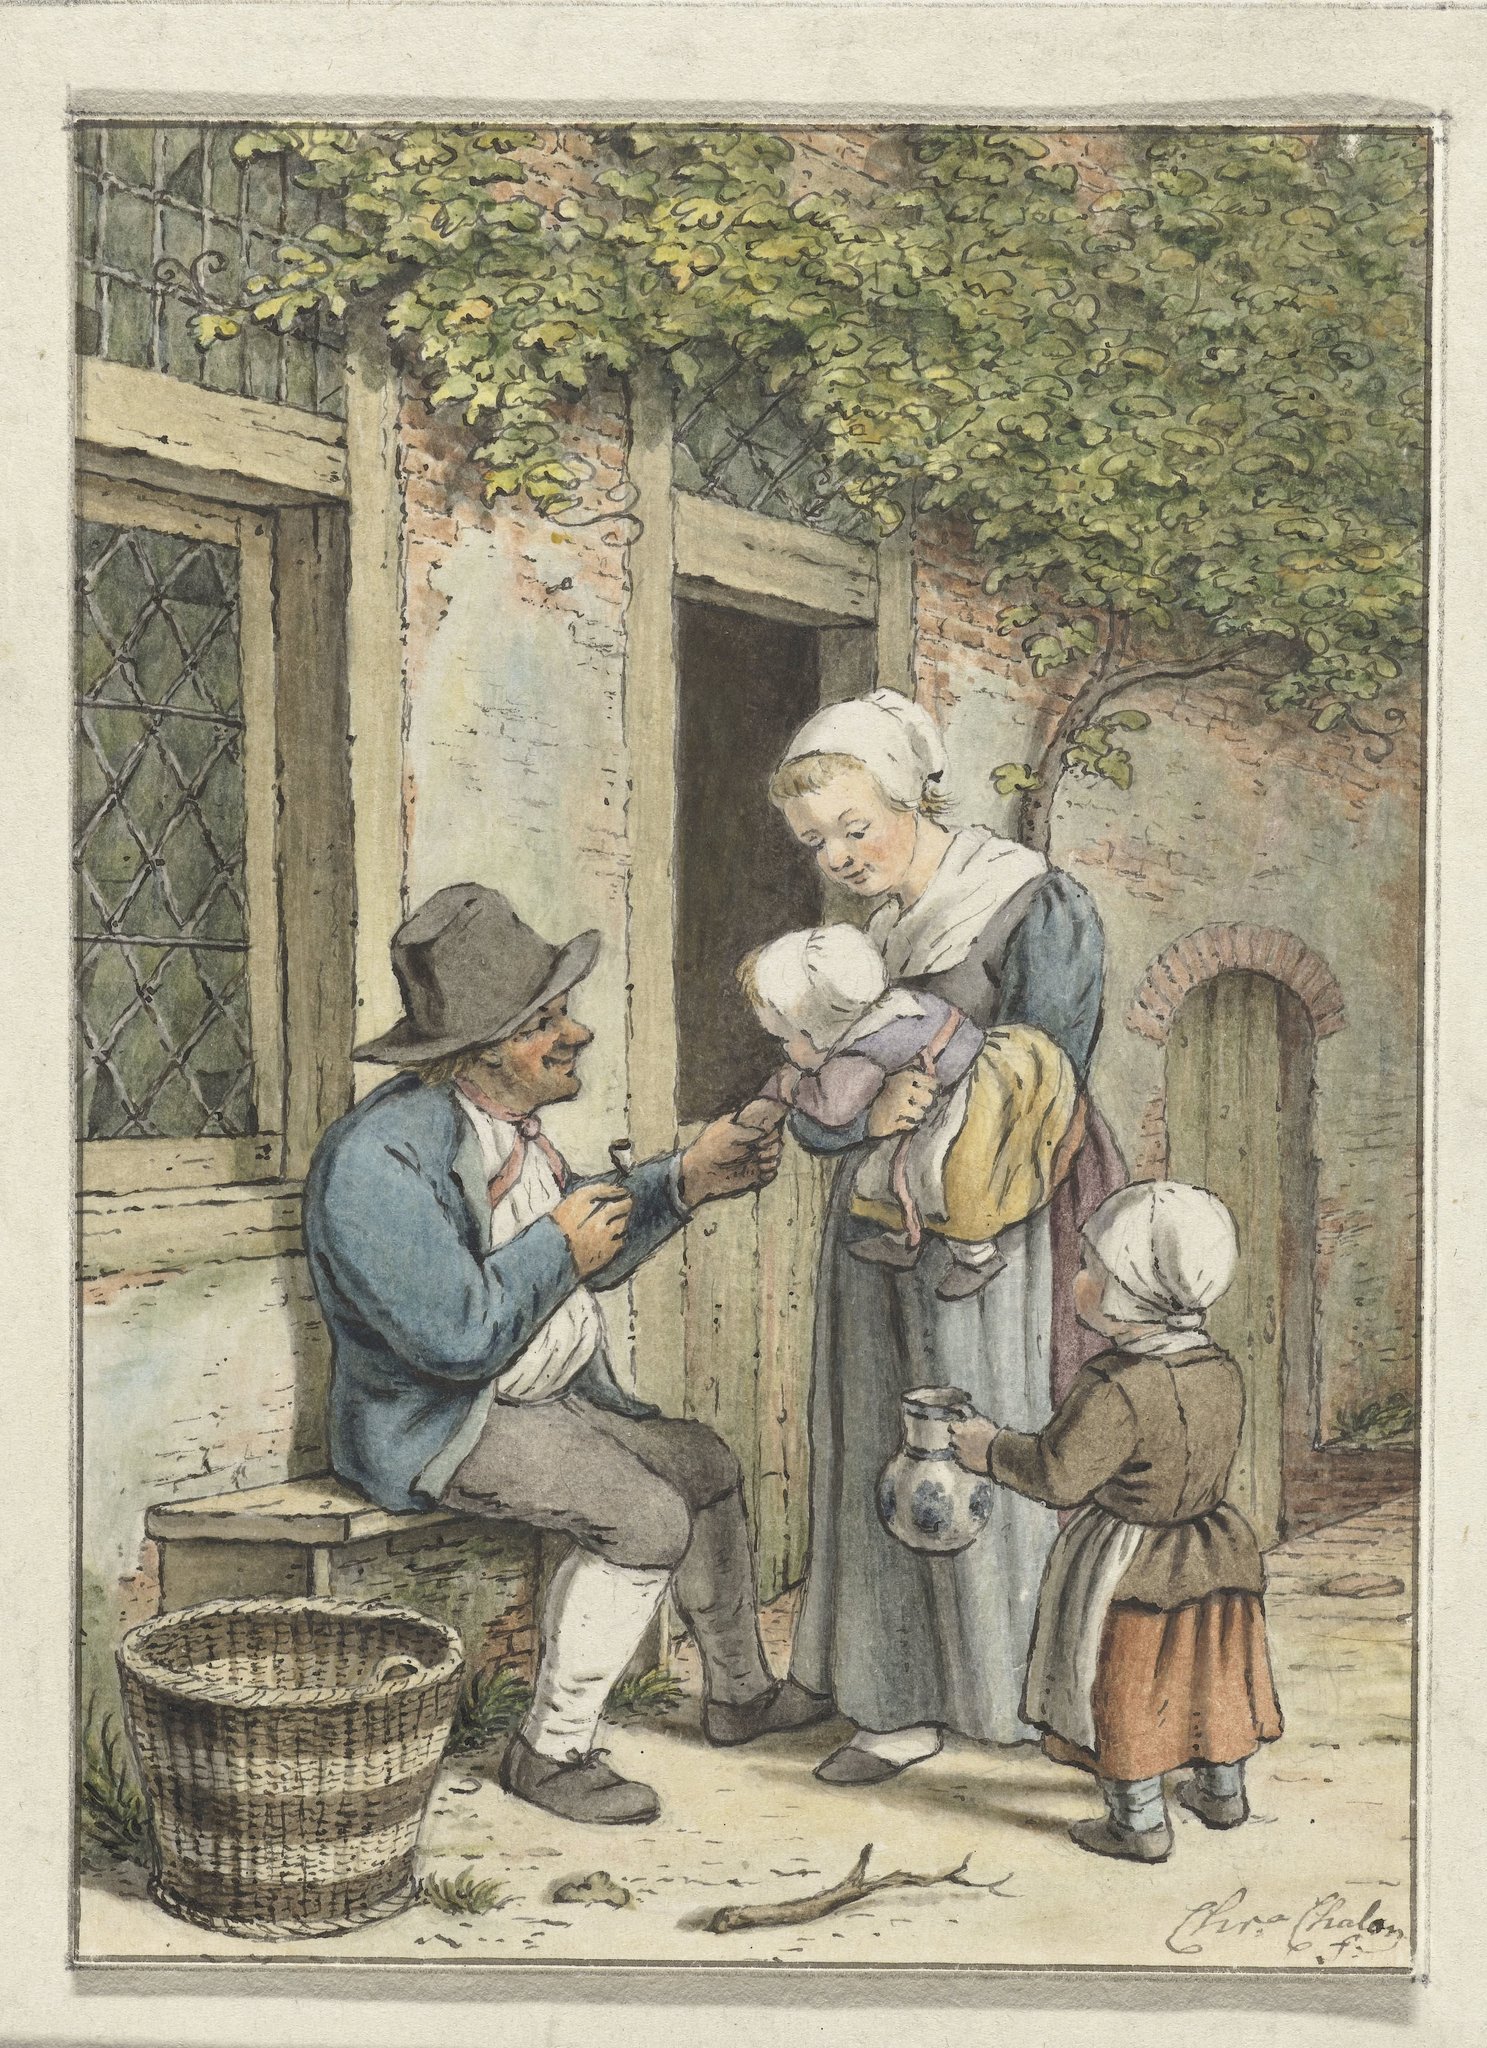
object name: watercolor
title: Boerenpraatje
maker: christina chalon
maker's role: draughtsman, print maker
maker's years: 1748-1808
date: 1758-1808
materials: ink, paper, watercolor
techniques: brush, pen